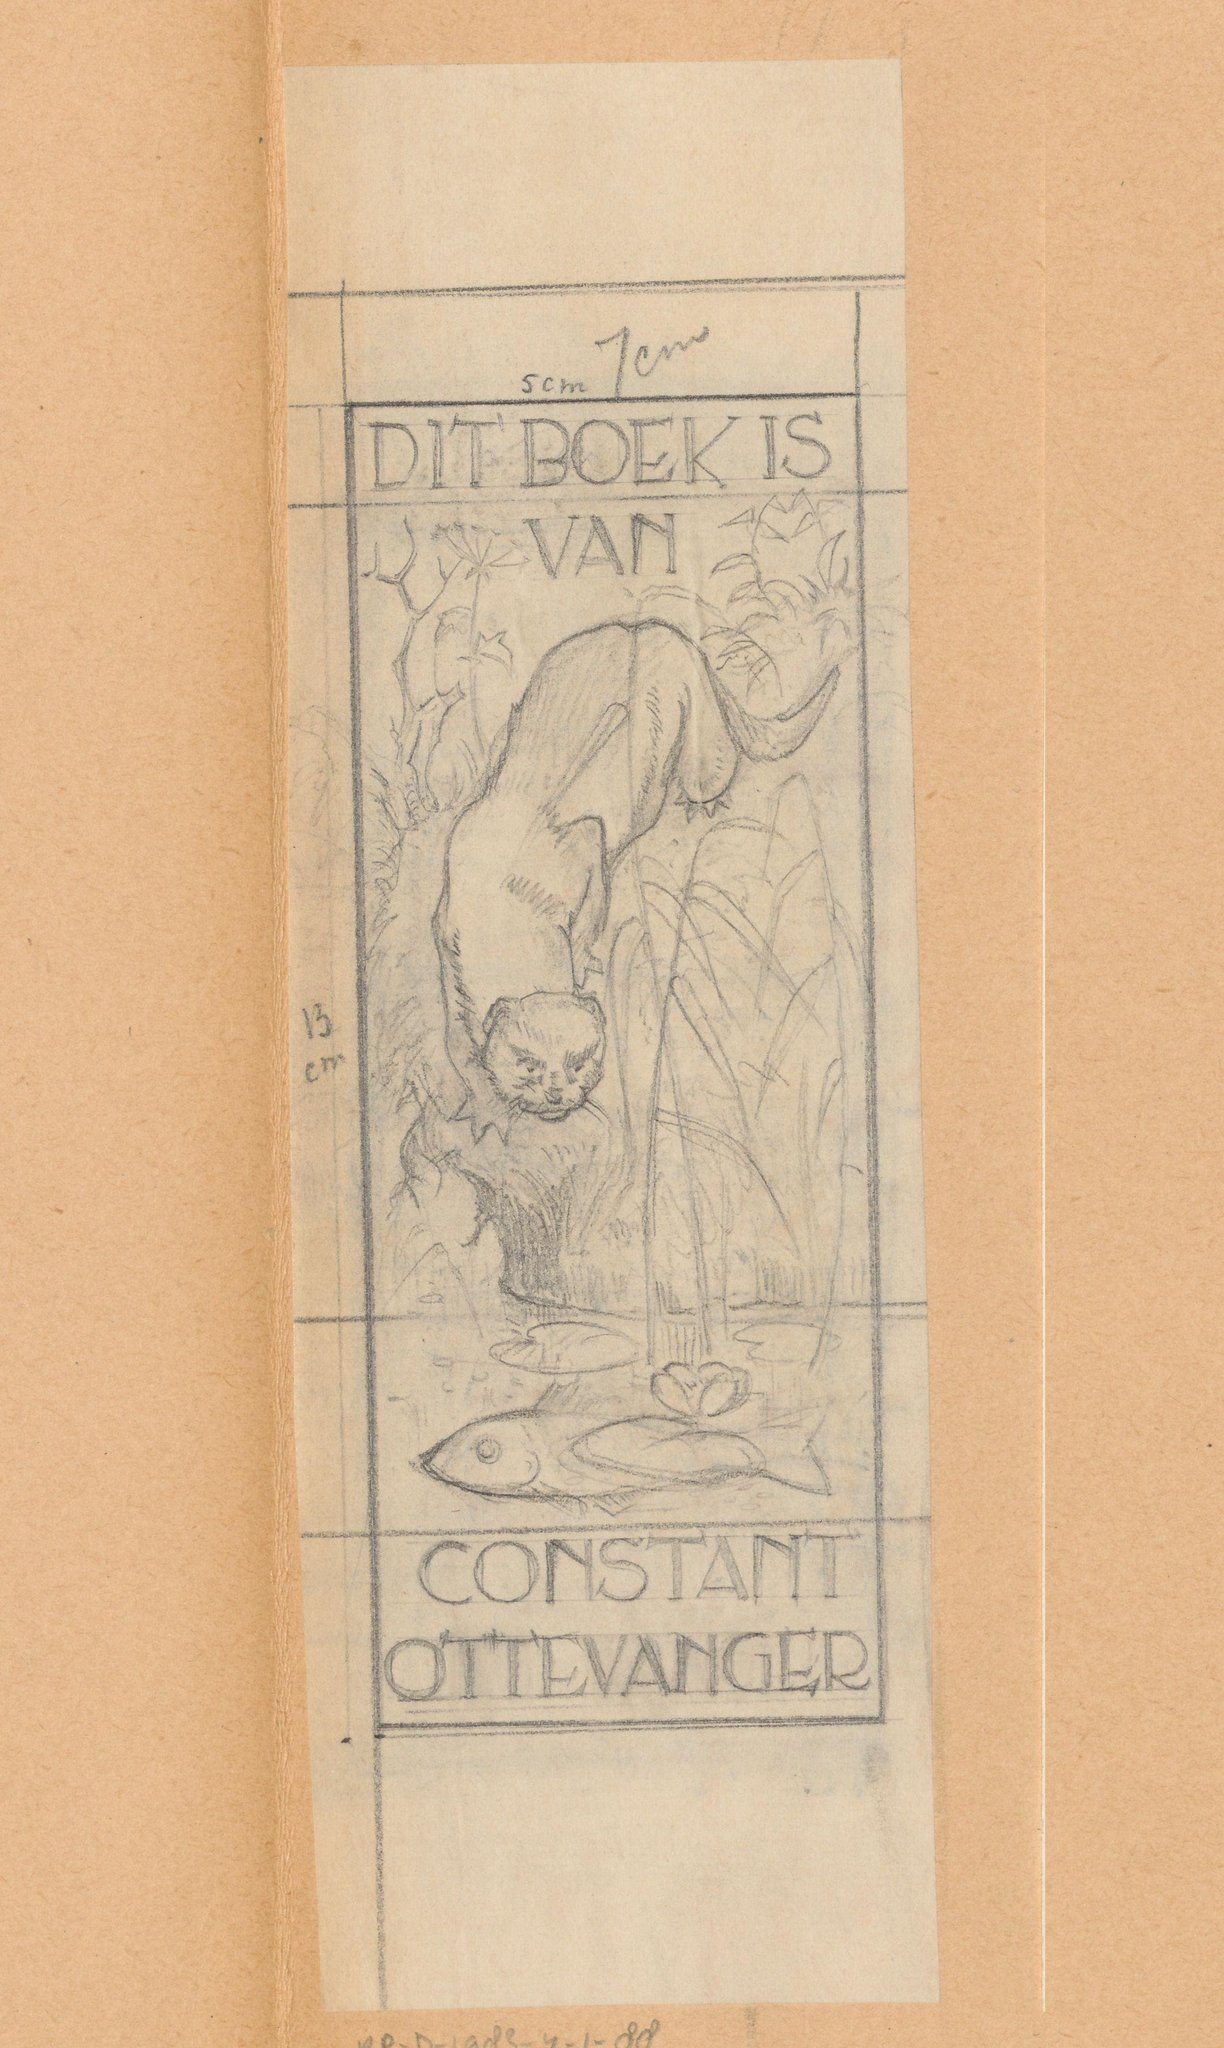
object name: design drawing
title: Dit boek is van Constant Ottevanger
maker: otto verhagen (i)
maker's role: draughtsman, print maker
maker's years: 1885-1951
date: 1933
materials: paper, pencil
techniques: drawing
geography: netherlands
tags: fishes, beasts of prey, predatory animals: otter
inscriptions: inscription: ‘5 cm/ 13 cm’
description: Ingezonden op een prijsvraag van B.M.W. Ottevanger. Niet in cliché uitgevoerd.